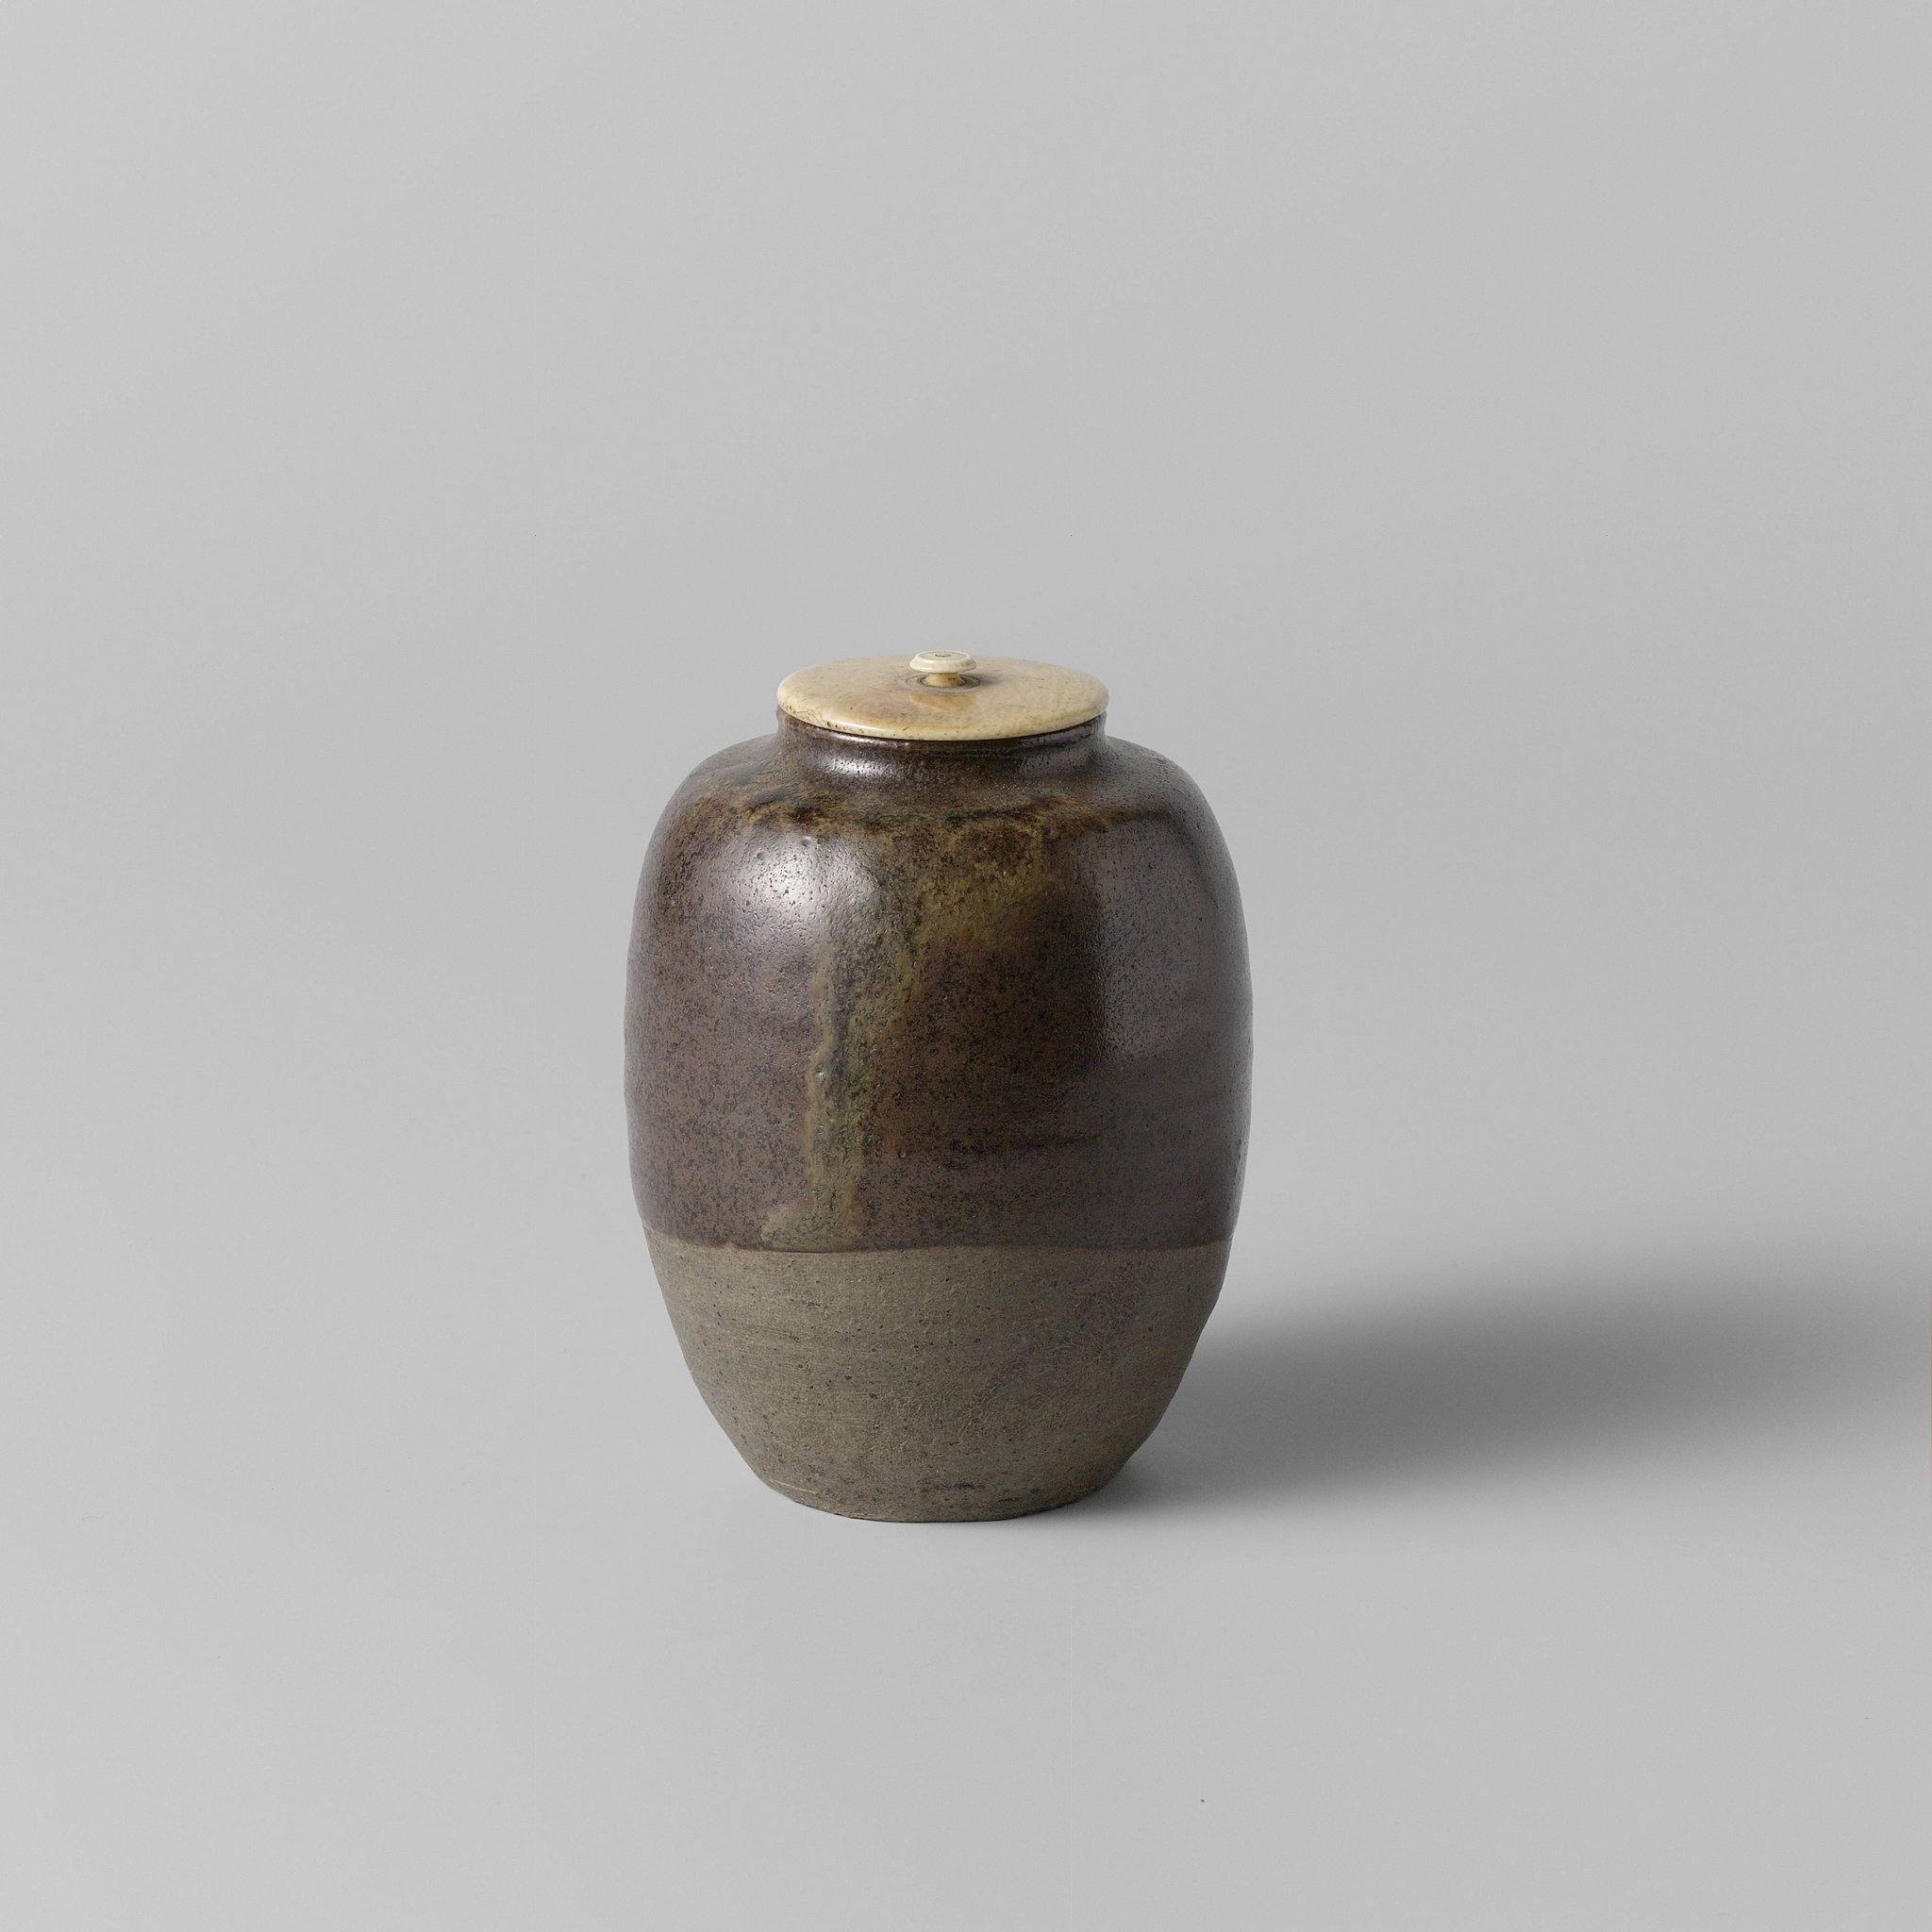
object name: chaire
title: Tea caddy with a brown glaze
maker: Anonymous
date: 1650-1699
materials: glaze, ivory, stoneware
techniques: firing, turning, vitrification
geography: tamba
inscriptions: label: ‘Tamba/ tweede helft 17e’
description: Stoftheebus of chaire van steengoed met een ivoren deksel, gedeeltelijk bedekt met een bruin glazuur. De onderste helft van de bus is ongeglazuurd. Oud label aan de binnenzijde met 'Tamba/ tweede helft 17e'. Tamba.